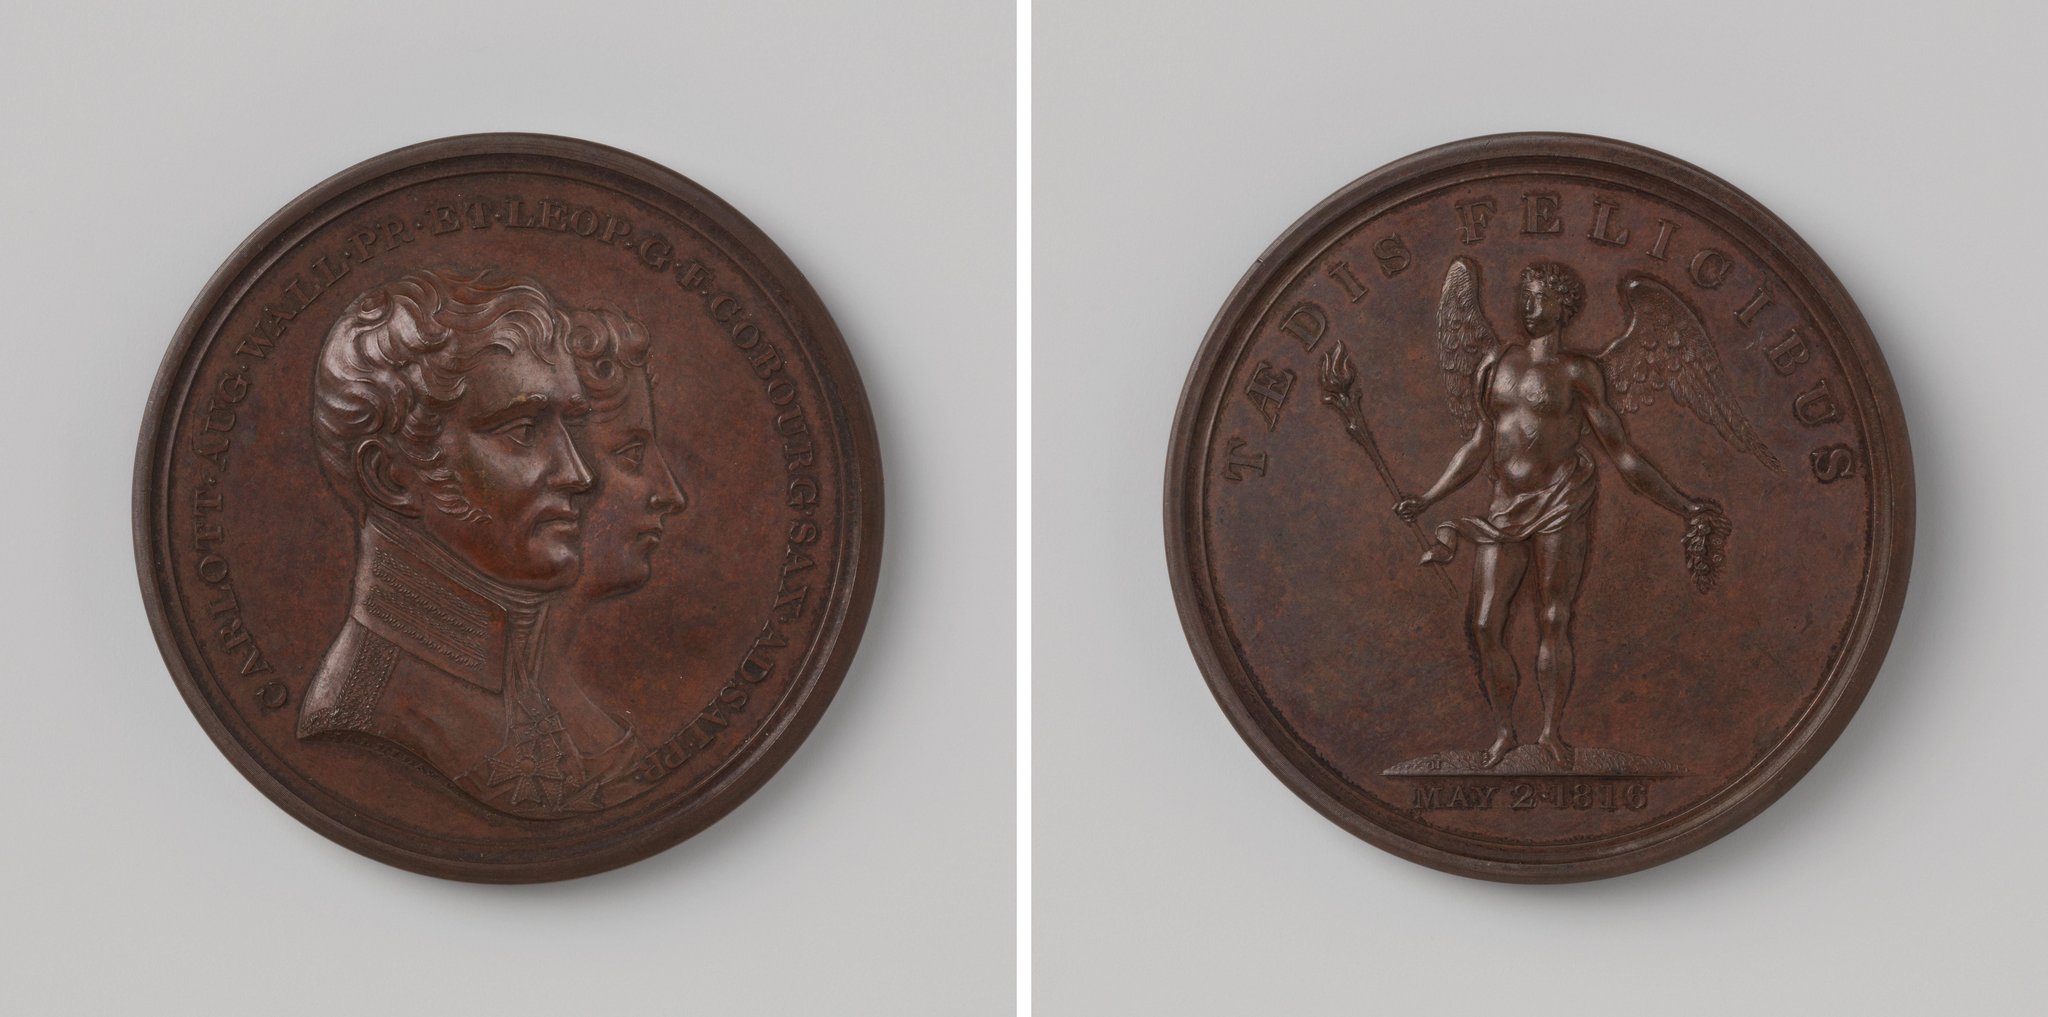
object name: history medal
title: Huwelijk van Leopold, prins van Saksen-Coburg en Charlotte Augusta, prinses van Engeland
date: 1816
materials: bronze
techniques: striking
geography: england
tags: london, charlotte augusta (prinses van wales), laeken, leopold i (koning der belgen)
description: Bronzen penning. Voorzijde: borststuk man en vrouw binnen omschrift. Keerzijde: gevleugelde huwelijksgod Hymen met brandende fakkel en bos bloemen in handen binnen omschrift; afsnede: datering